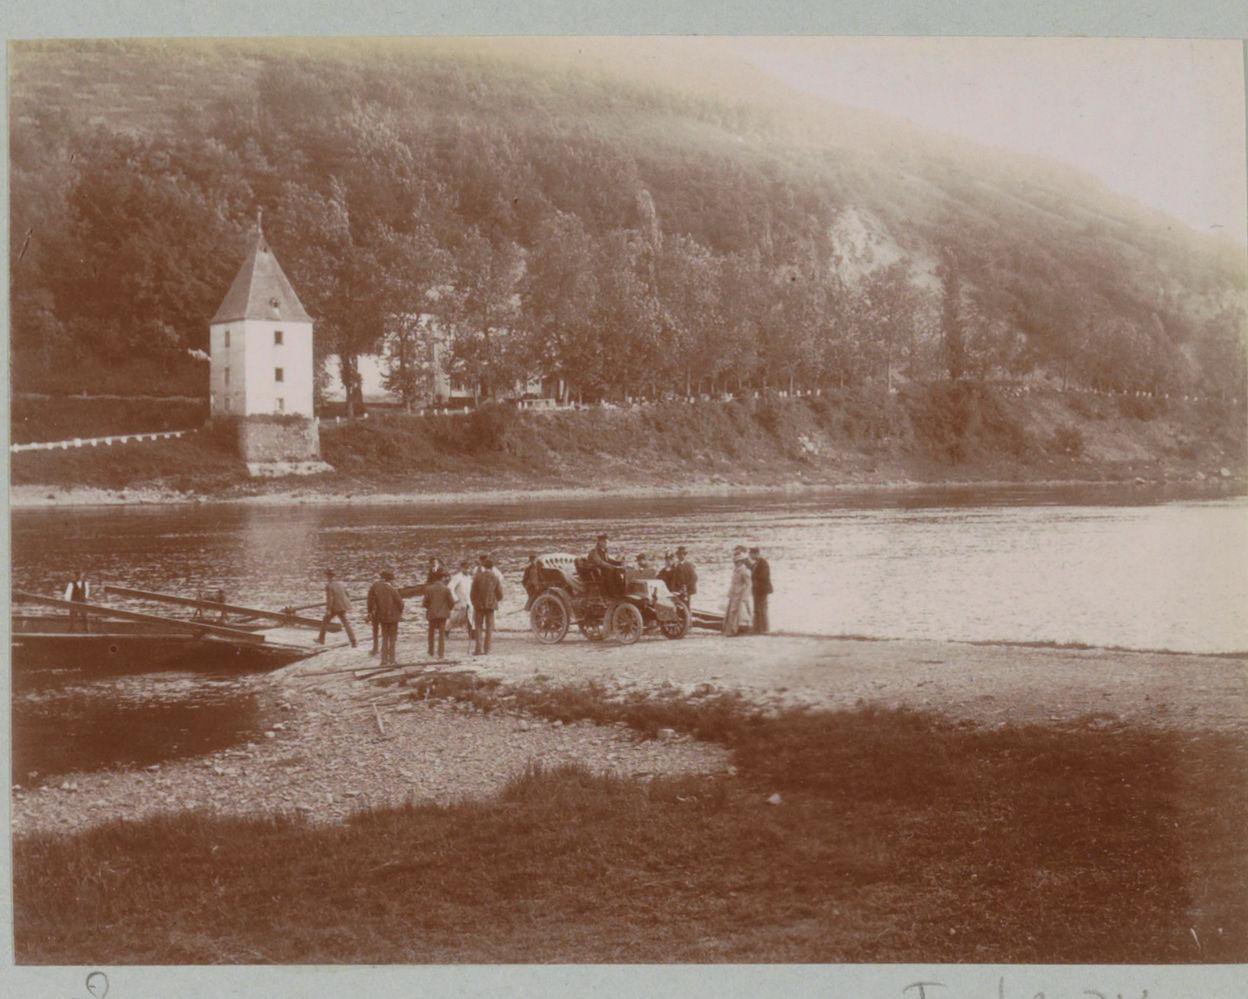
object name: photograph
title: Gezelschap met een automobiel bij een veer te Bernkastel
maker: delizy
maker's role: manufacturer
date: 1900-1906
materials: paper, photographic support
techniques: gelatin silver print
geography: rhineland-palatinate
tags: ferry, automobile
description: Onderdeel van Fotoalbum van een Franse amateurfotograaf met opnames van uitstapjes in Frankrijk, Spanje, België, Luxemburg en Nederland, de eerste automobielen en autoraces.